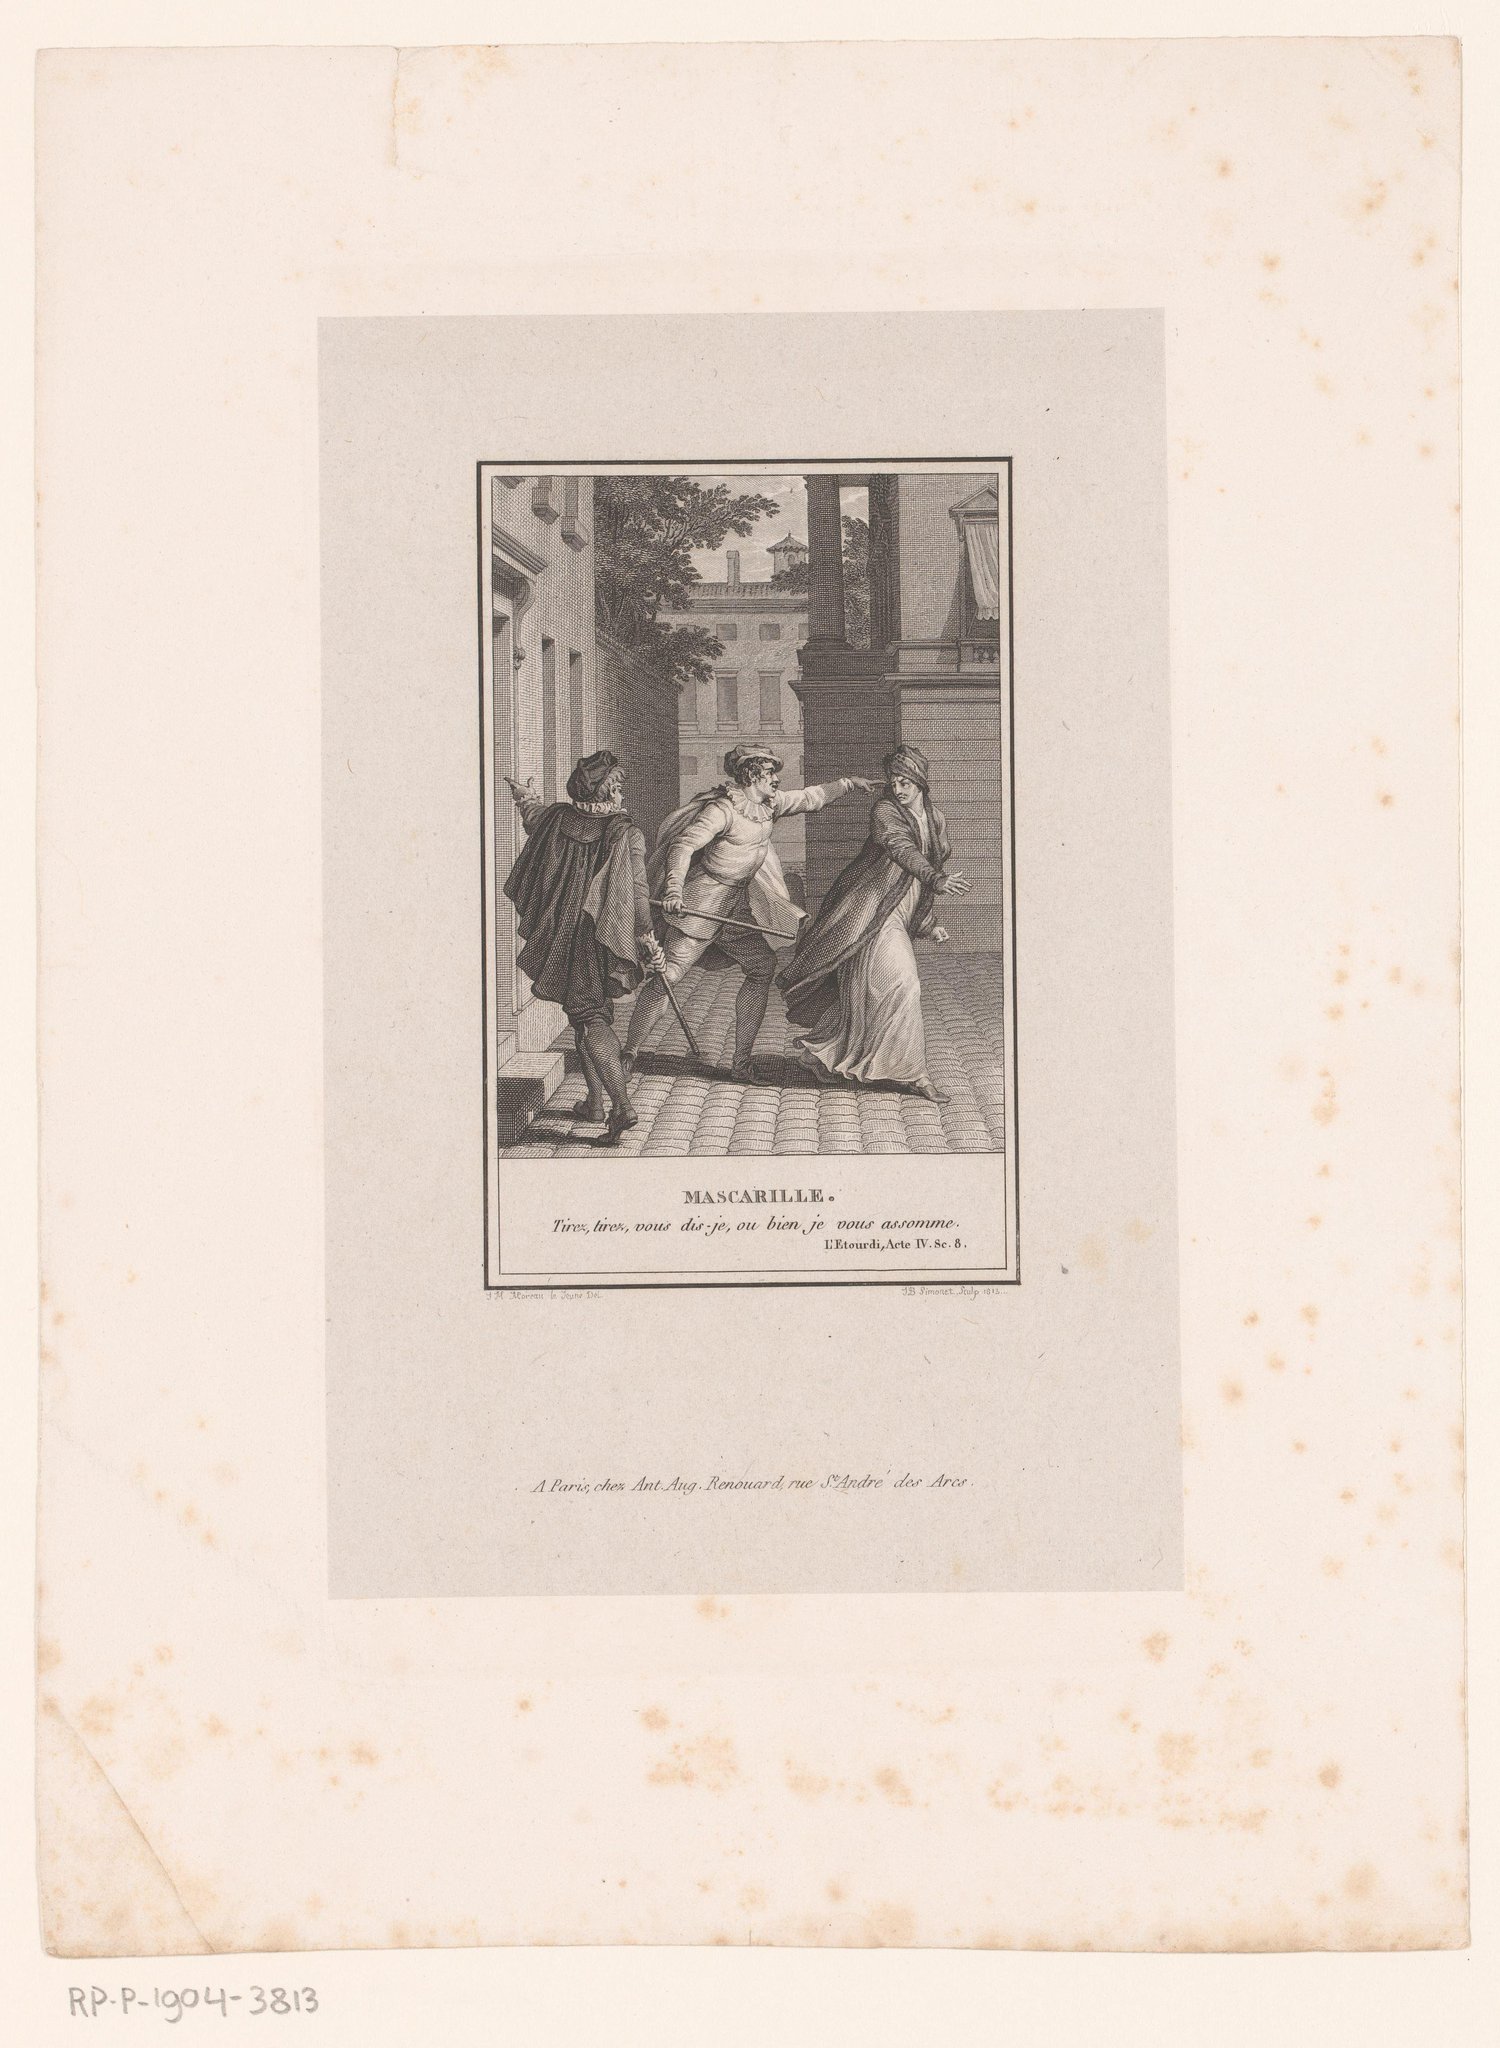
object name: print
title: Man in gewaad wordt weggejaagd door twee mannen met stokken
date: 1811-1813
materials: paper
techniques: engraving, etching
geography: paris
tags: comedy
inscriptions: collector's mark: Lugt 2228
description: Prent van scène acht van de vierde acte uit 'L'Etourdi' door Jean Baptiste Molière. Dit betreft één van de dertig prenten, gemaakt in opdracht van Antoine Augustin Renouard, bestemd voor verschillende edities van Molières werk daterend van 1811 tot 1813. De prenten zijn vervaardigd door verschillende kunstenaars naar composities van Moreau.